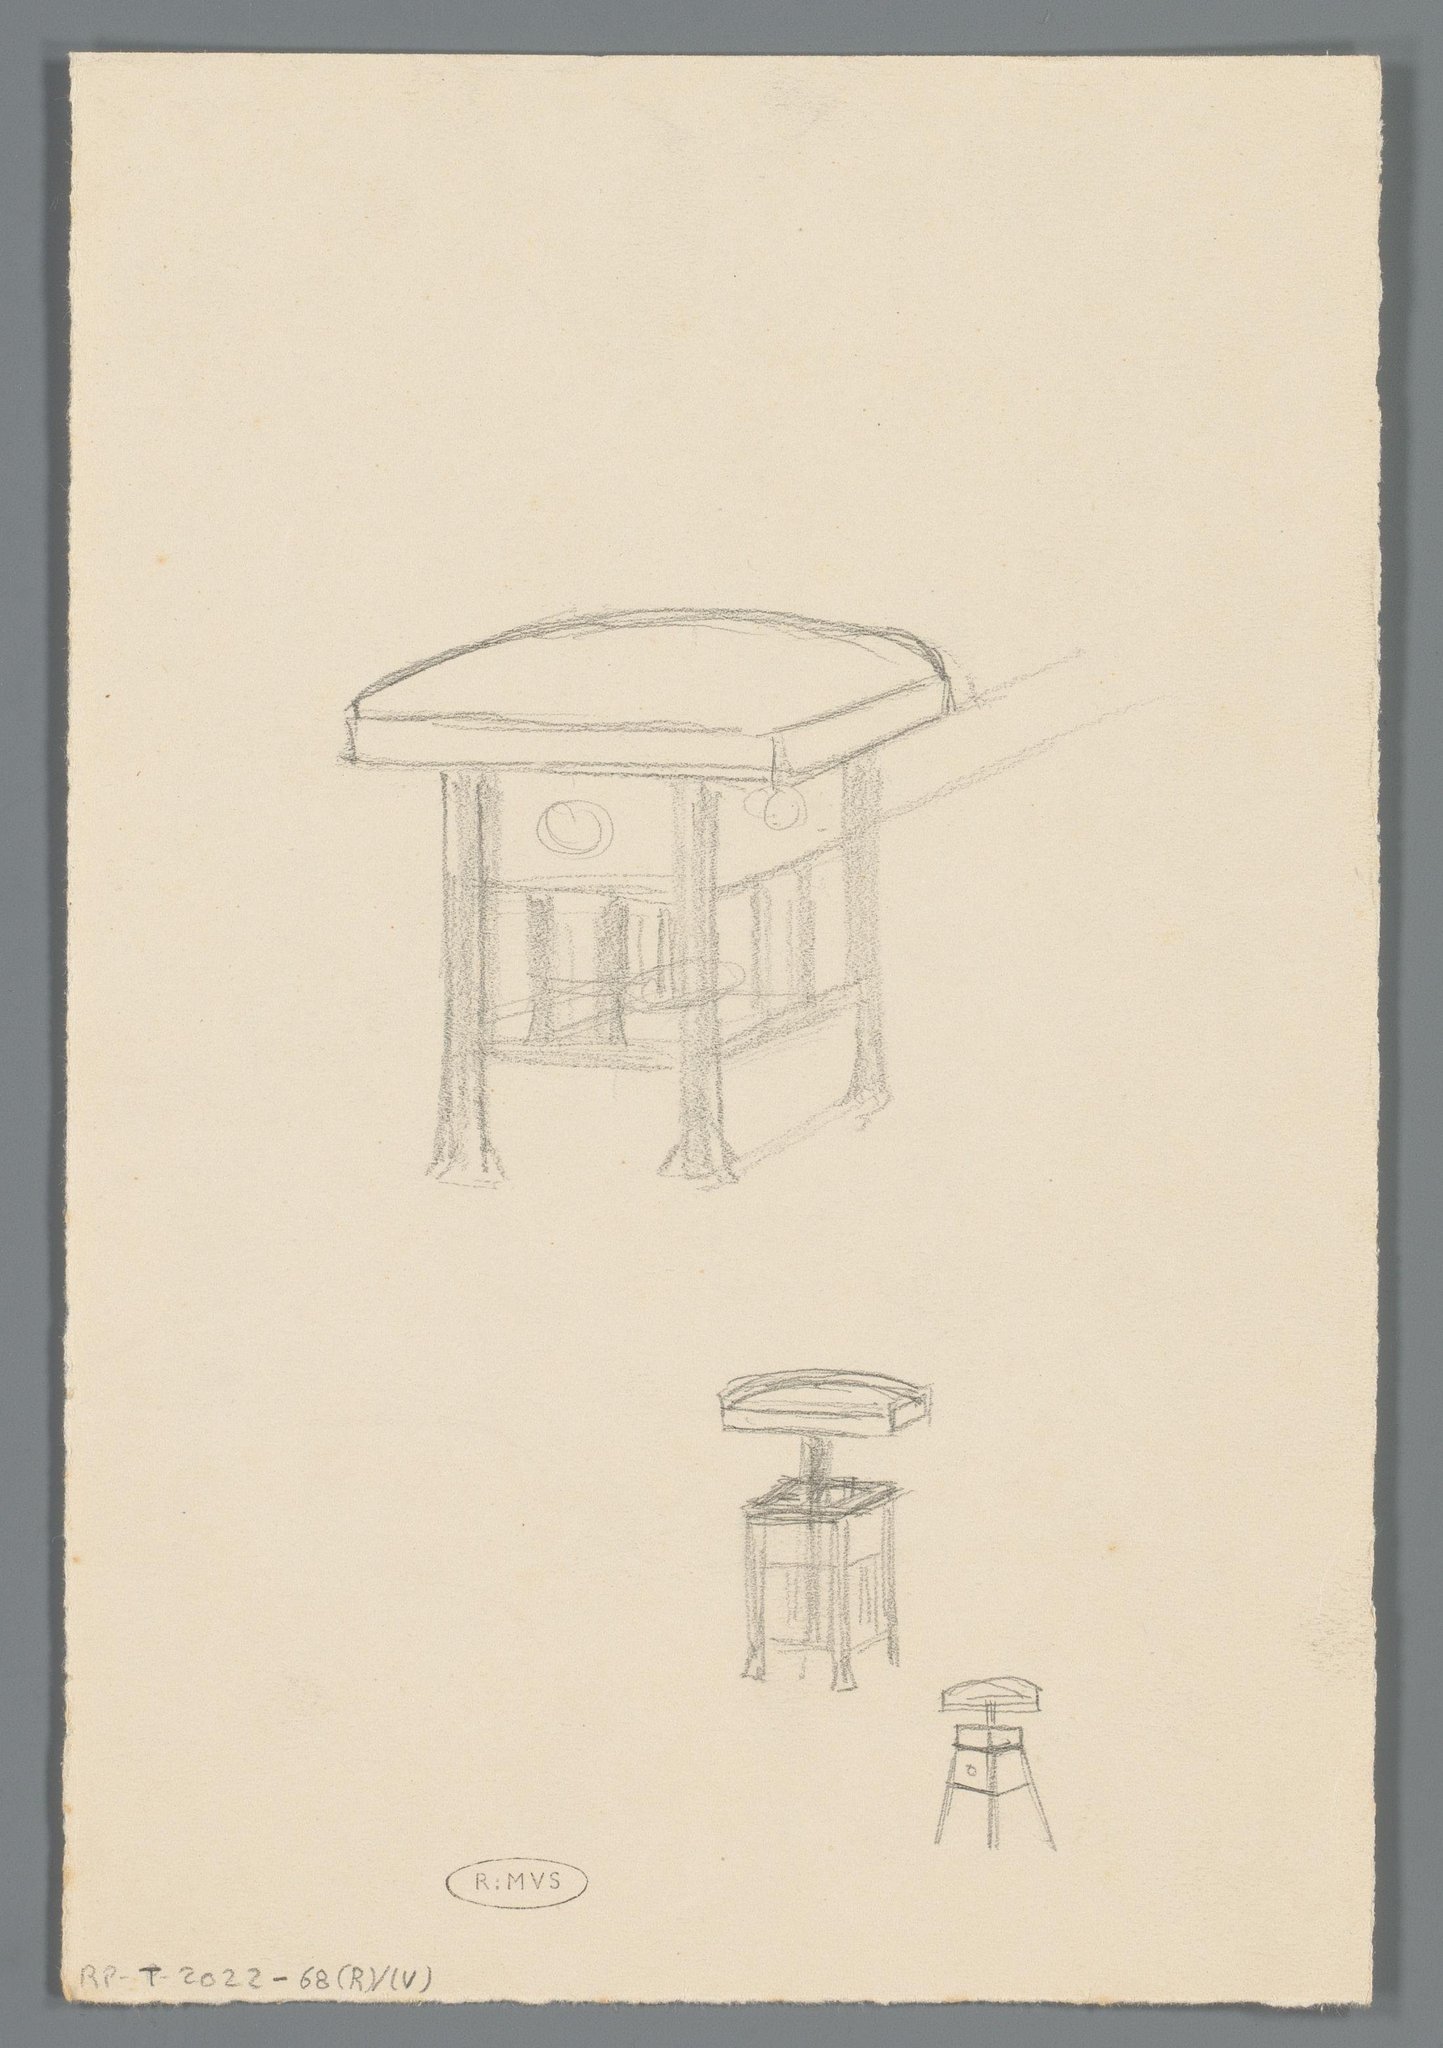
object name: design drawing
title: Ontwerp voor een kruk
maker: gust van de wall perné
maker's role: draughtsman, painter, print maker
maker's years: 1877-1911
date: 1887-1911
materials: paper, pencil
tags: stool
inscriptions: collector's mark: Lugt 2228